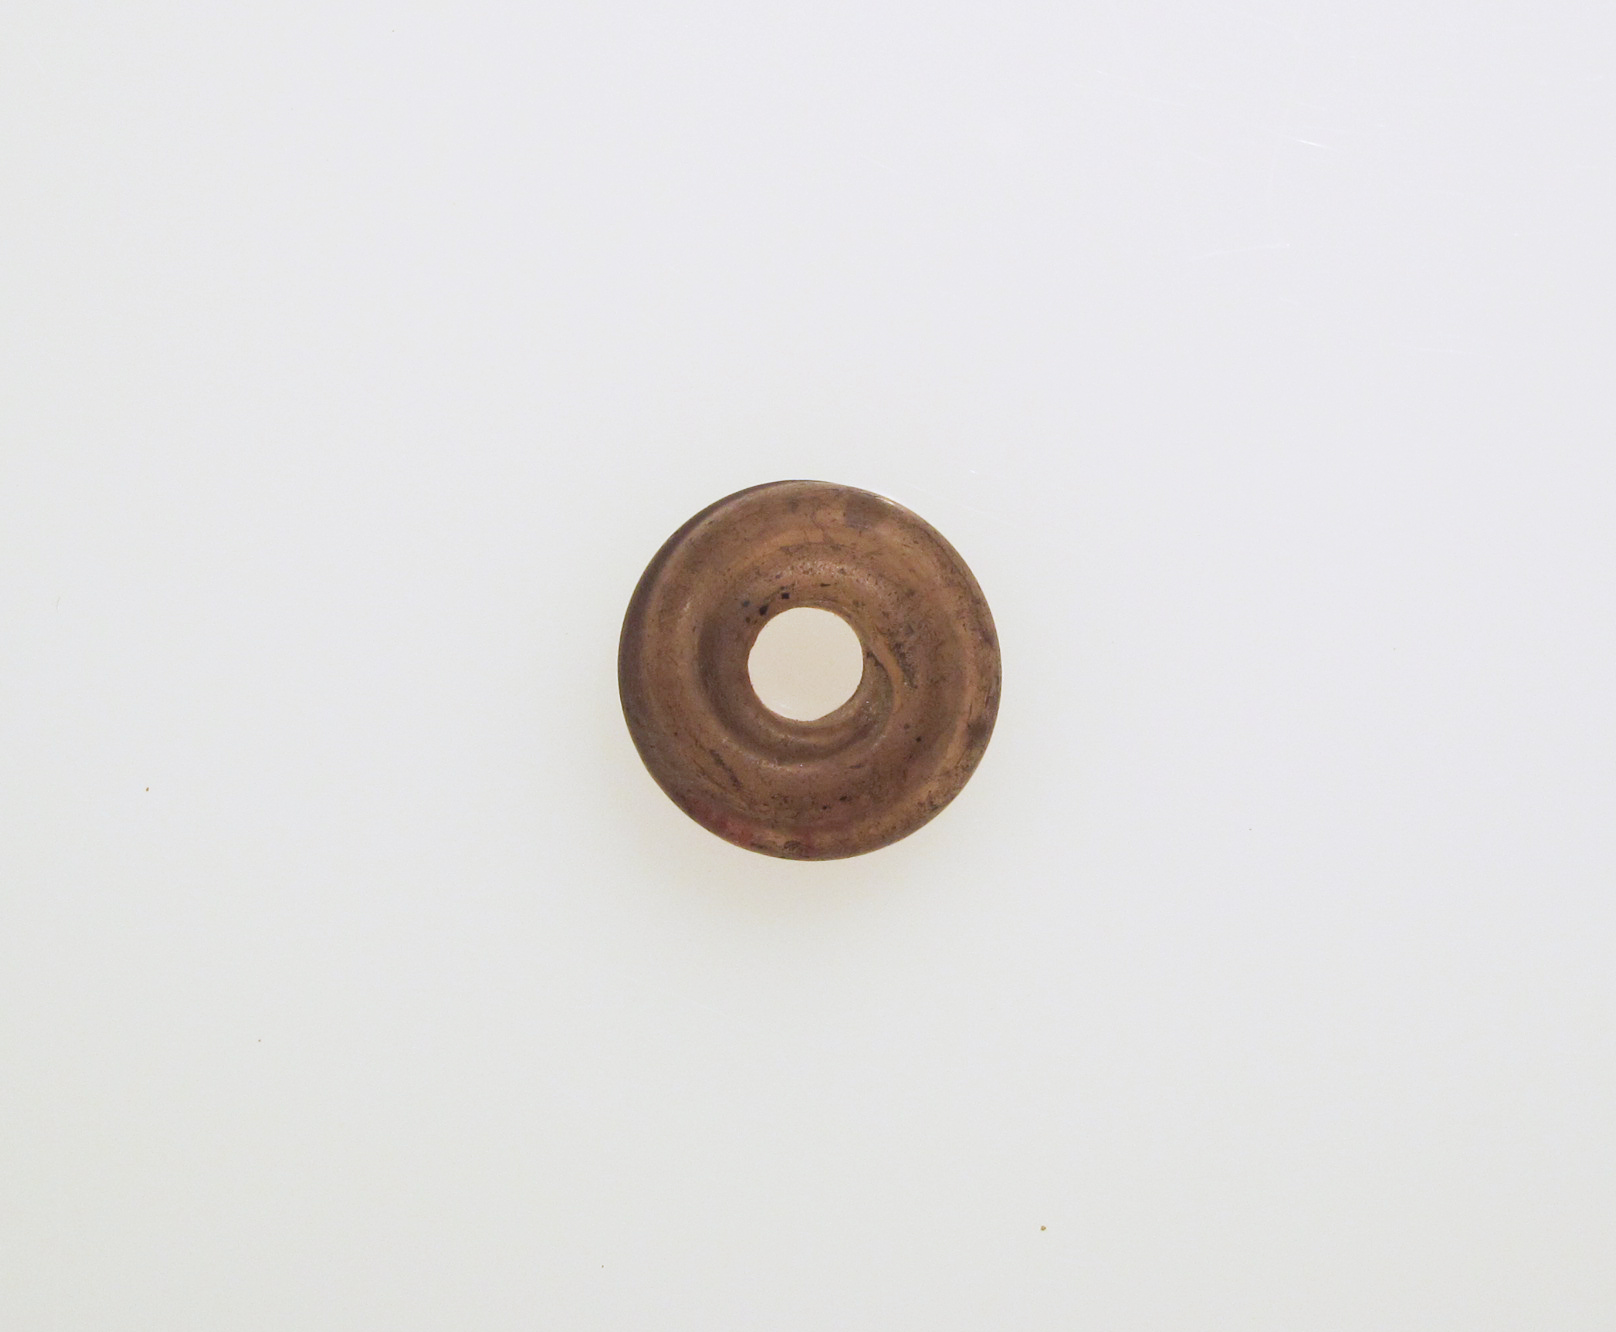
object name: bead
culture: roman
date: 670 BCE-330 CE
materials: glass